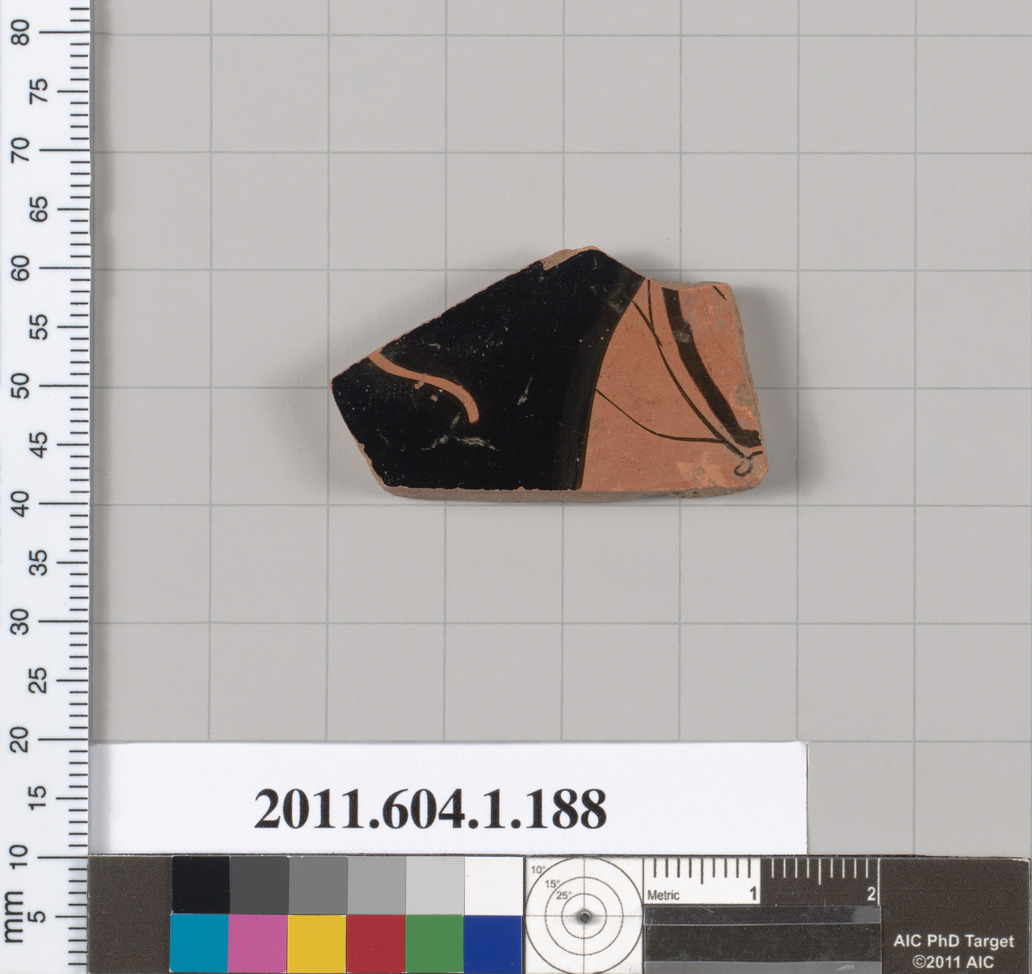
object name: kylix fragment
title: Terracotta fragment of a kylix (drinking cup)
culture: greek, attic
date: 475-451 BCE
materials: terracotta